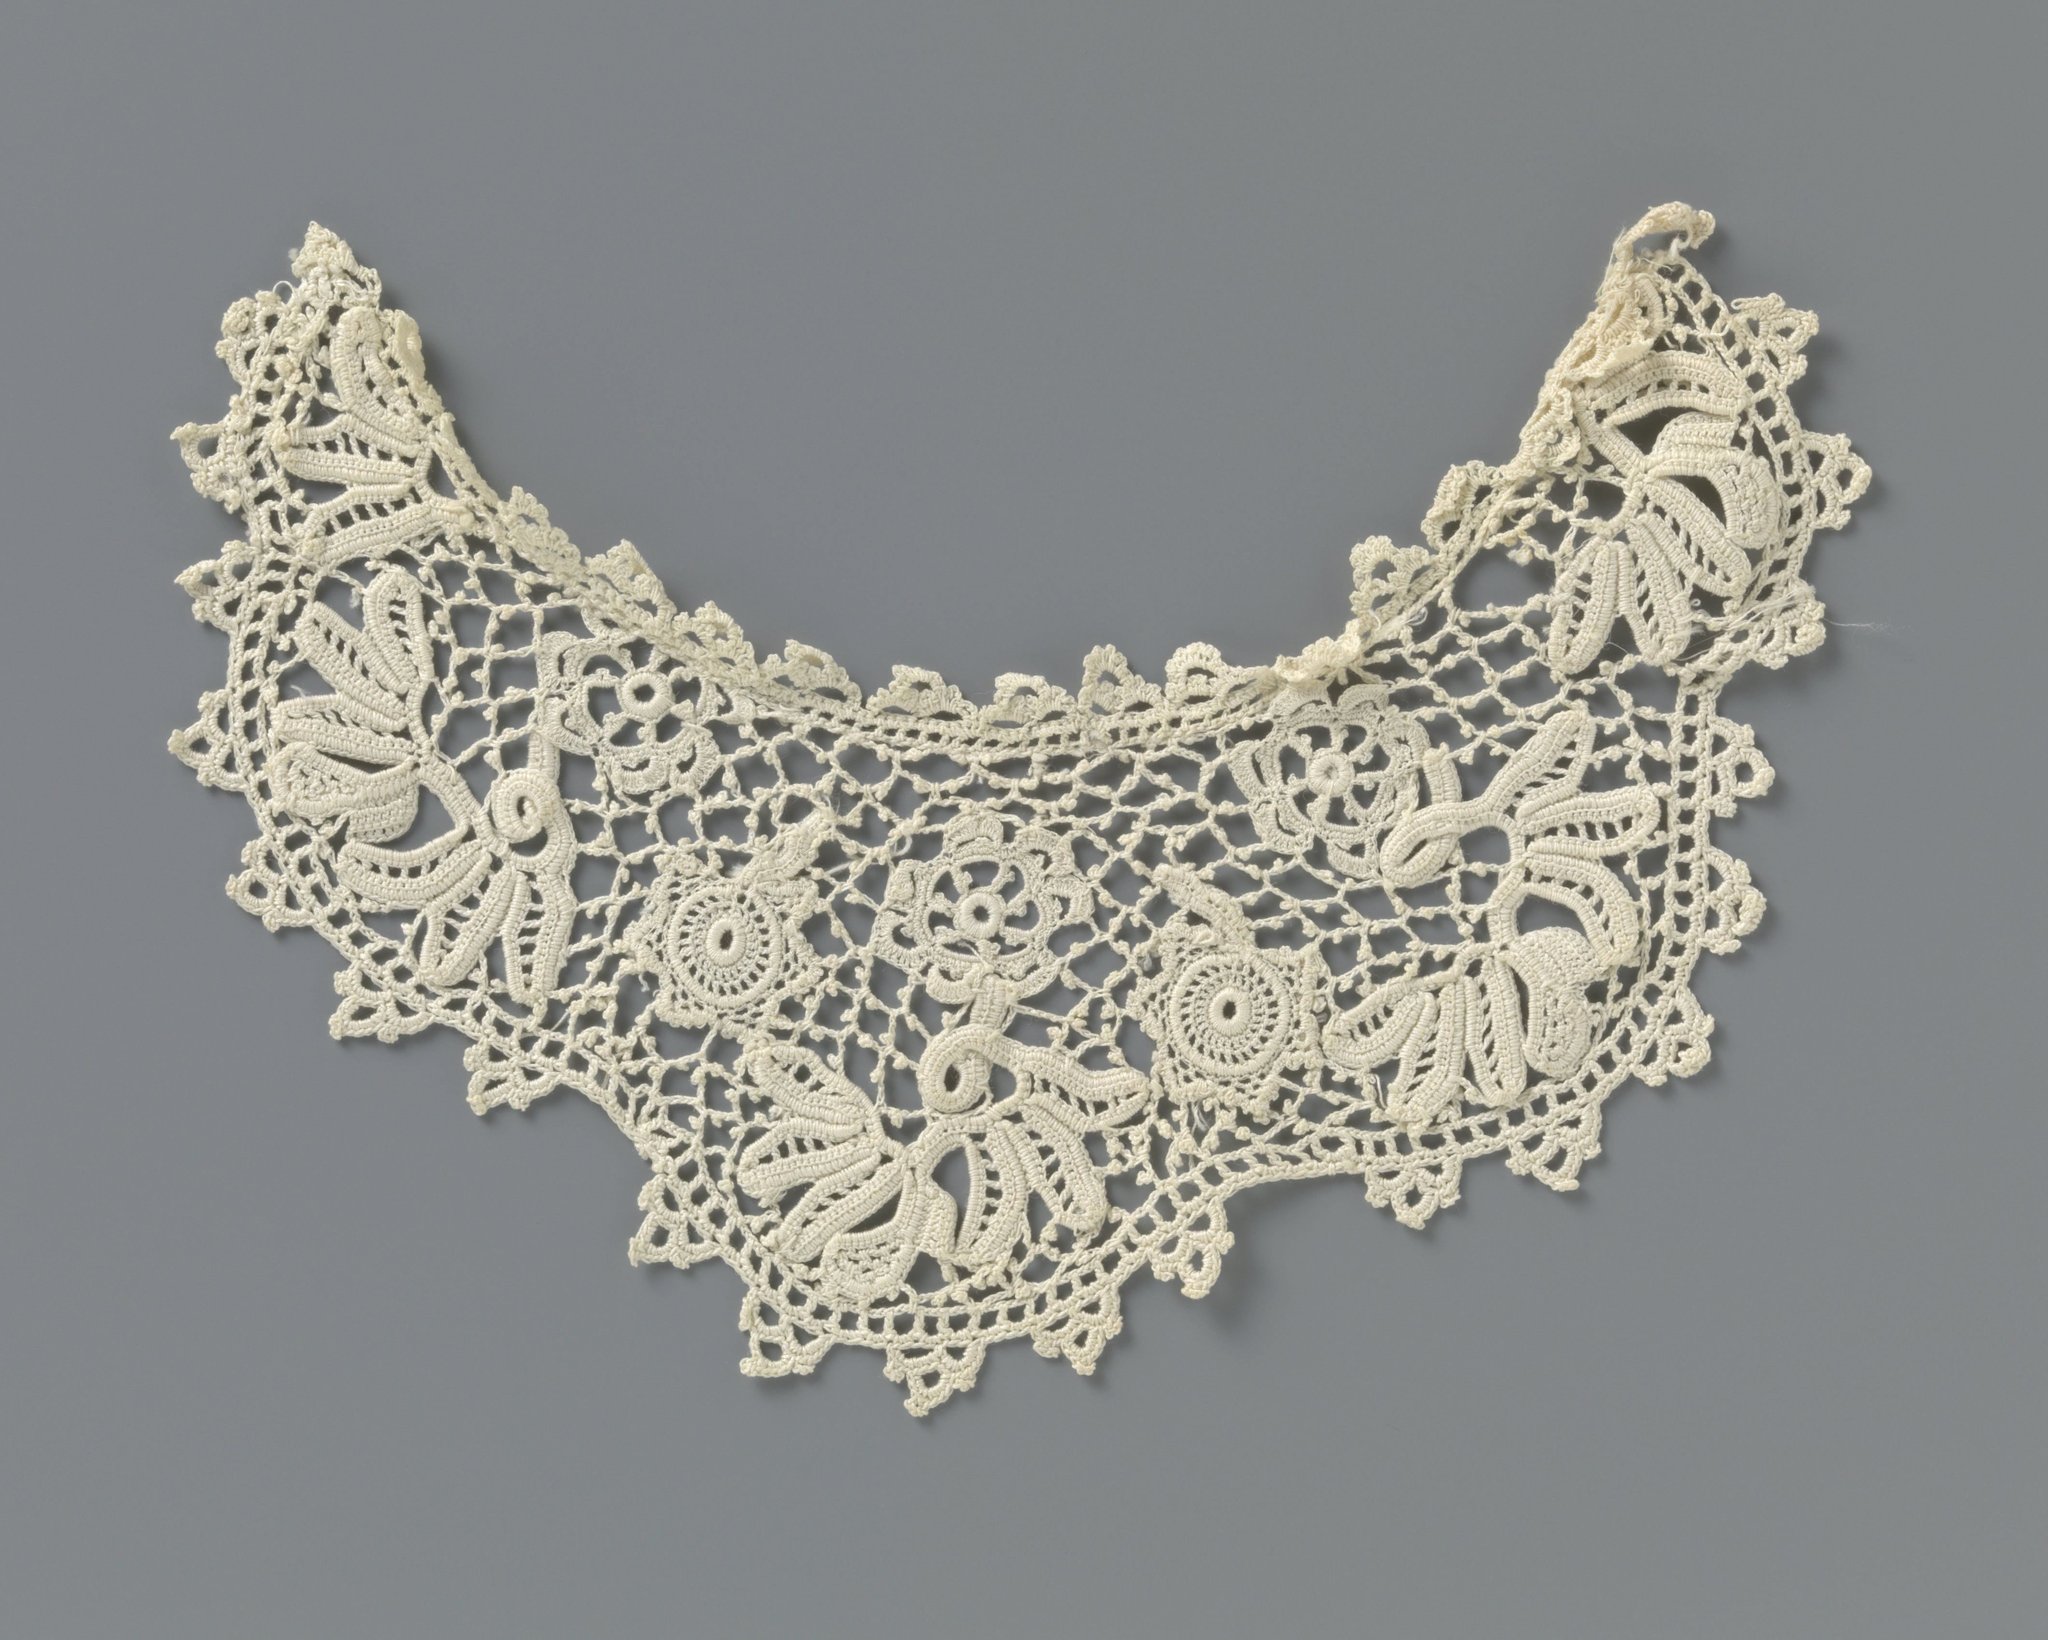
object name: oplegstuk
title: Oplegstuk van gehaakte kant met getorste stengels en rozetten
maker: Anonymous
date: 1890-1909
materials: cotton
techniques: crocheted lace, irish crochet lace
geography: ireland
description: Het is een aanname dat deze Ierse gehaakte kant ook daadwerkelijk in Ierland is gemaakt. Ierse gehaakte kant kent zijn oorsprong rond 1760 en kwam vanaf 1840 in ontwikkeling. Aangezien volgens Martine Bruggeman (Kant in Europa) de Ierse haakindustrie aan het eind van de 19e eeuw gereorganiseerd werd en in populariteit groeide, is het hier beschreven stuk gedateerd rond 1890, tot 1909 vanwege de datering in het eerste decennium van populariteit van Ierse gehaakte kant volgens het Kantlexicon (Johan Coene).